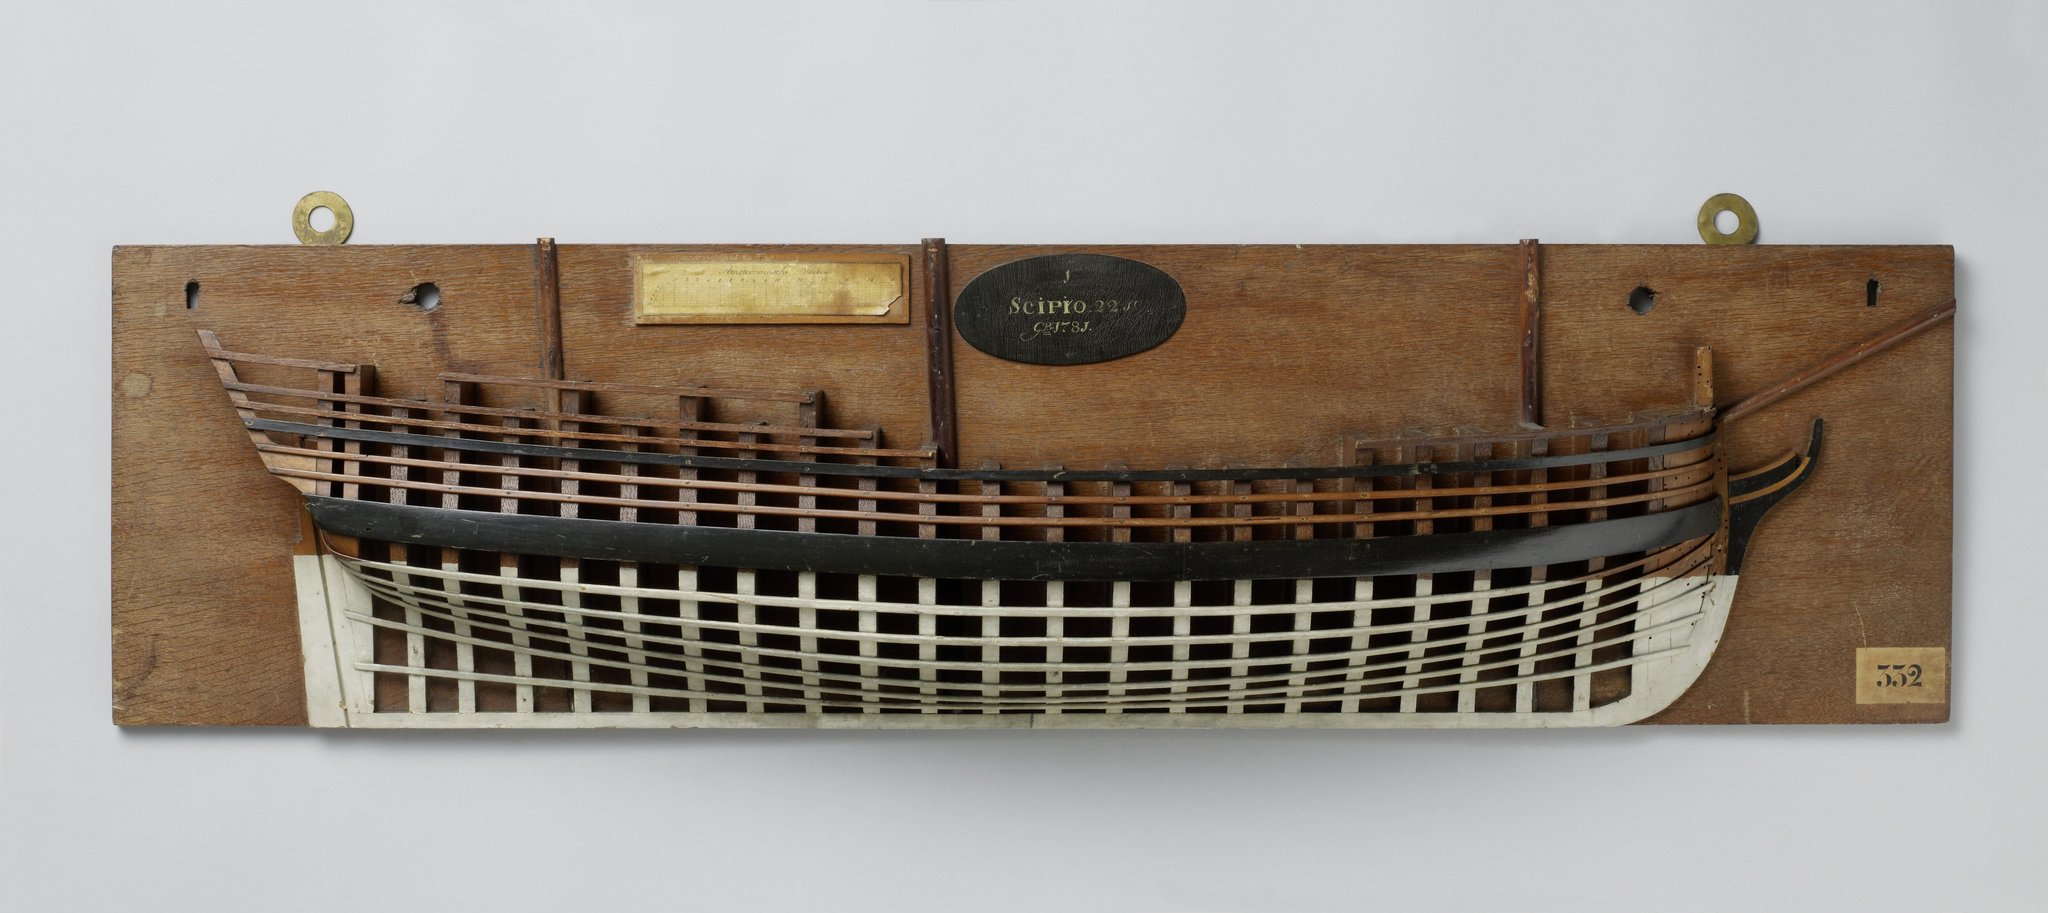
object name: builder's model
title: Half Model of a 22-Gun Sloop of War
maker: Anonymous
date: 1781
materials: wood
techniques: polychromy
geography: netherlands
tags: scipio (schip)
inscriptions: scale, top centre: paper scale in Amsterdam feet, label, bottom right: ‘332’ former inventory label, inscription, top centre, on an oval black label: ‘1 / SCIPIO. 22 St / GB: 1781.’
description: De korvet Scipio van 22 stukken werd in 1781 van de Fransen gekocht.